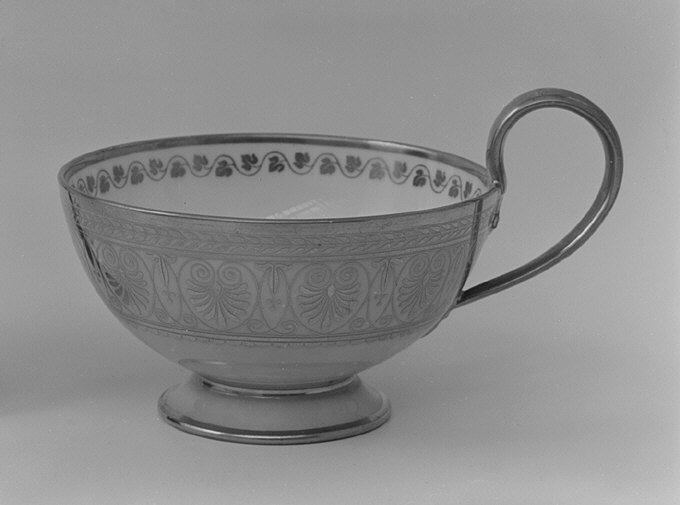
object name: cup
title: Cup (part of a service)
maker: sèvres manufactory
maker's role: manufactory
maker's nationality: french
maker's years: 1740-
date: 1845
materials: hard paste porcelain